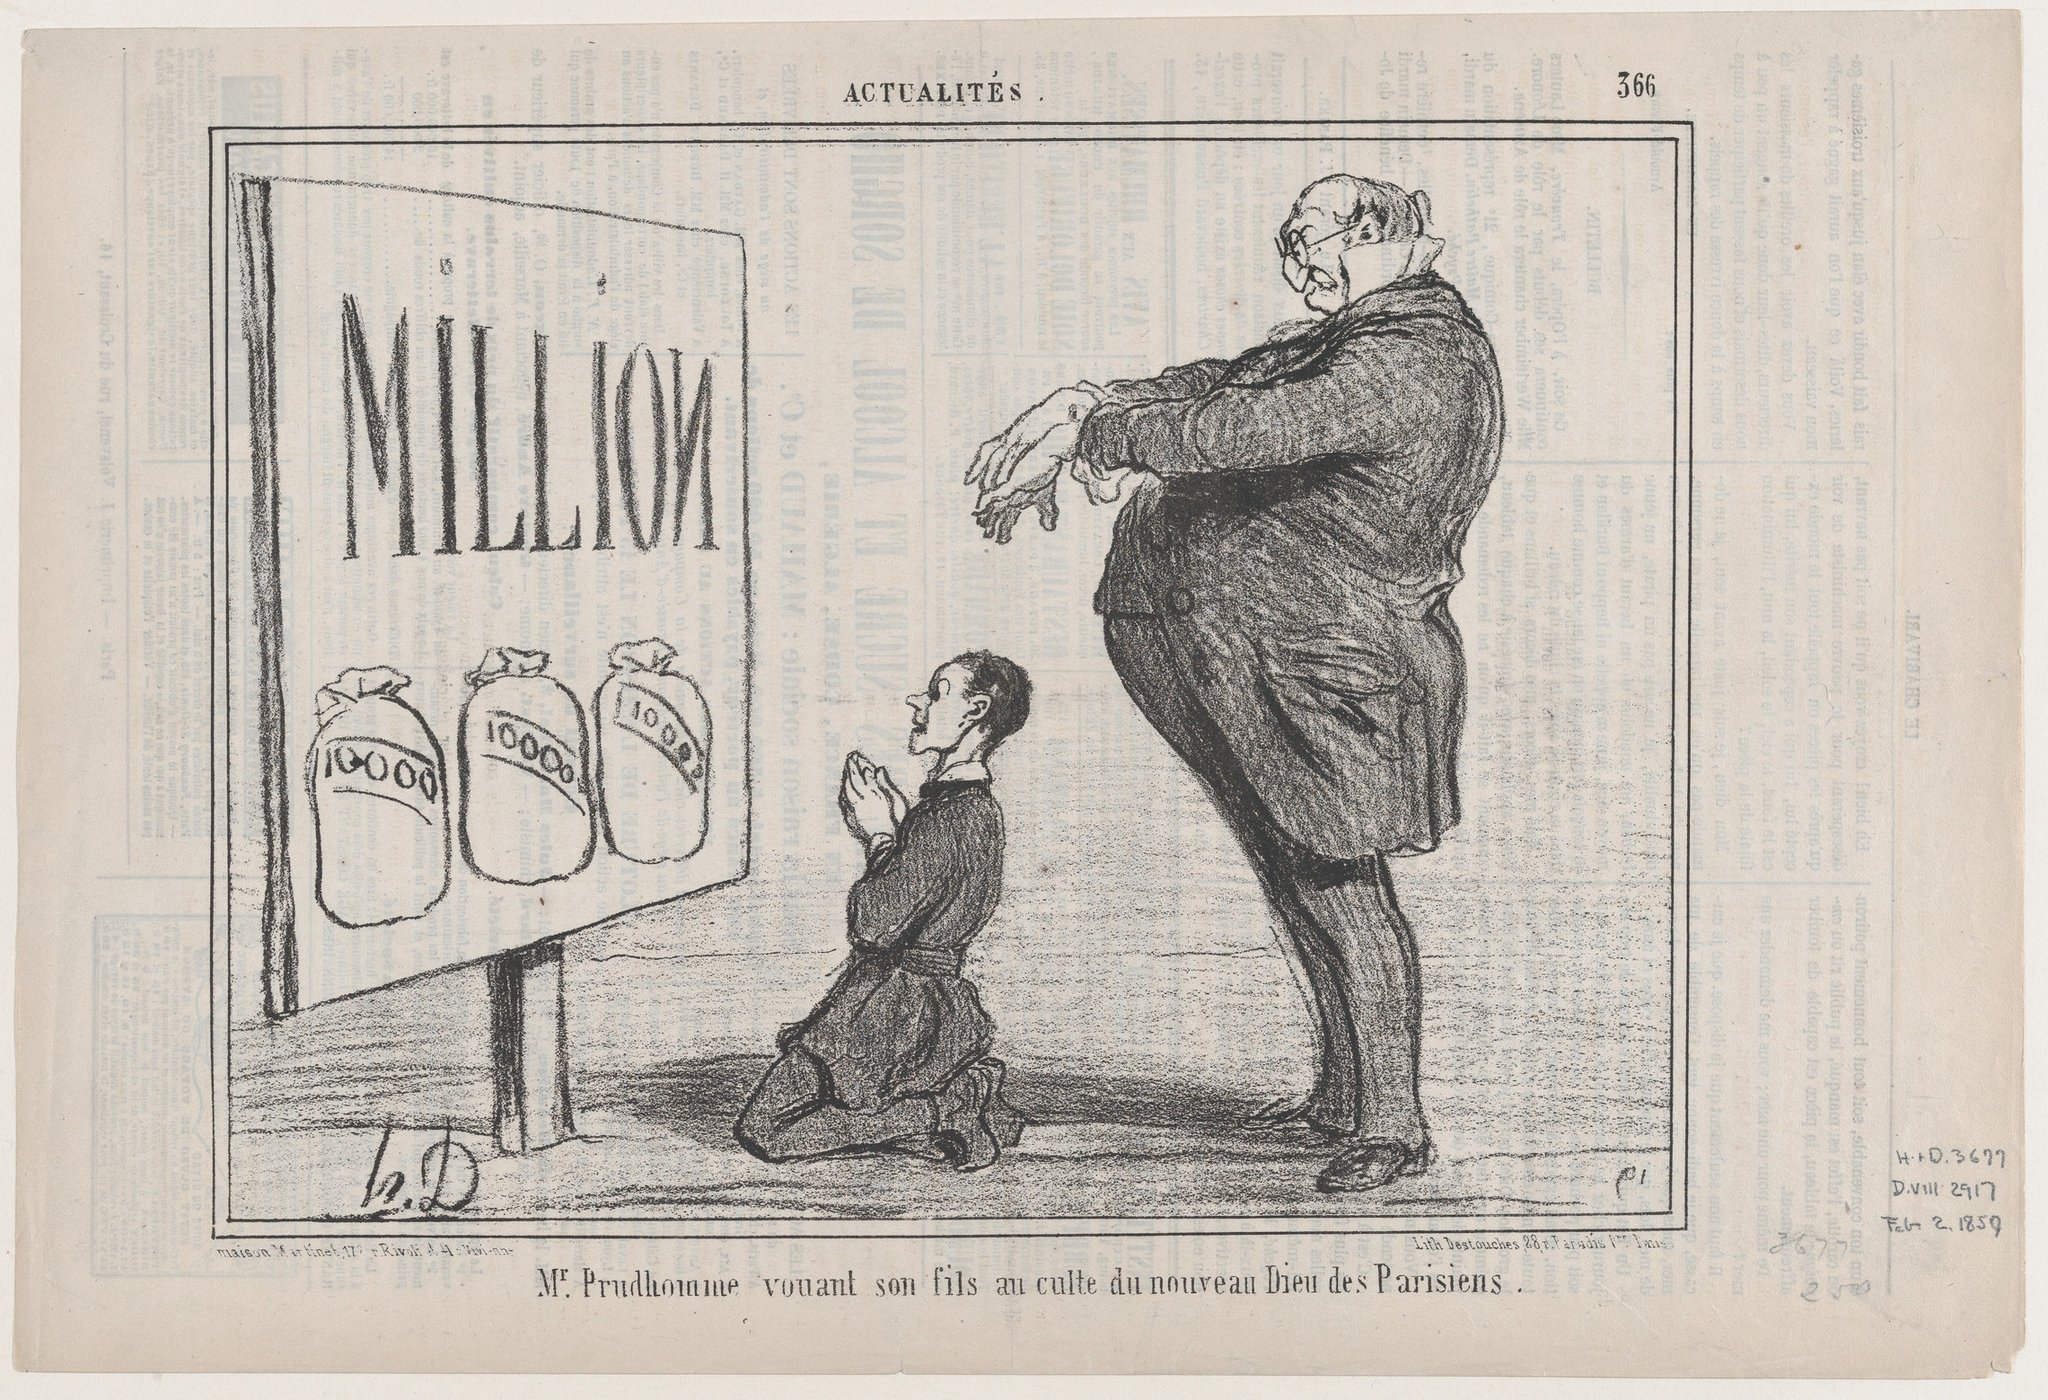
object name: print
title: Mr. Prudhomme vouant son fils au... nouveau dieu..., from "Actualitès"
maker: honoré daumier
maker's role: artist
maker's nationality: french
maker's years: 1808-1879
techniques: lithograph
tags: boys,men